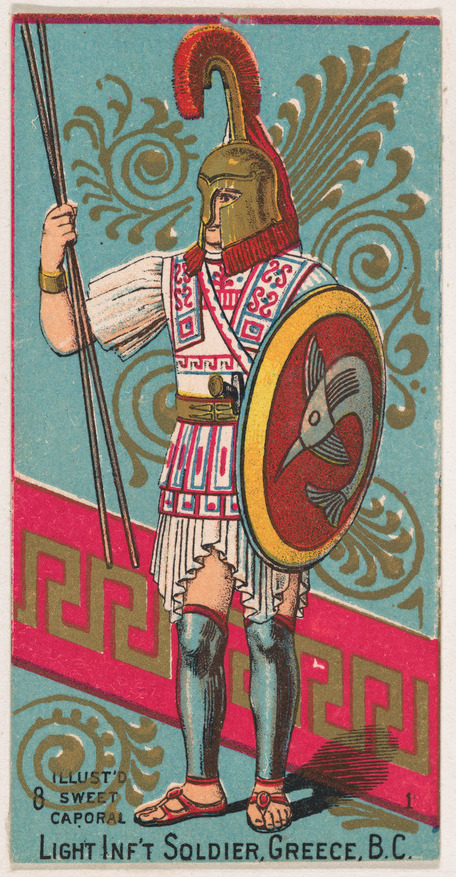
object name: print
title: Light Infantry Soldier, Greece, B.C., from the Military Series (N224) issued by Kinney Tobacco Company to promote Sweet Caporal Cigarettes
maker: kinney brothers tobacco company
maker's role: publisher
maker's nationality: american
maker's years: 1869-2011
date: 1888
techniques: color lithograph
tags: military,soldiers,shields,men